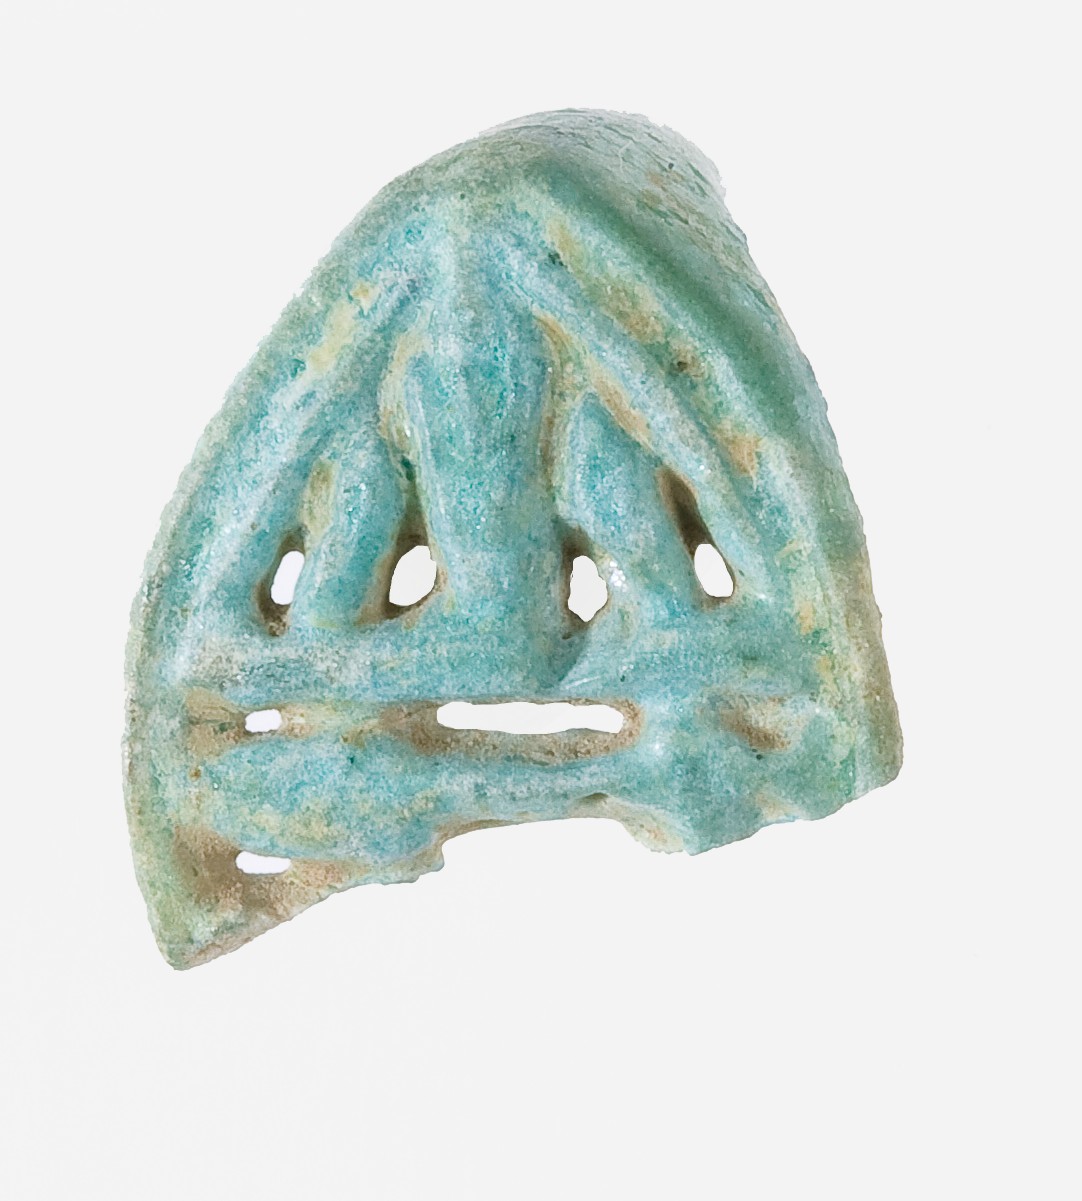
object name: ring fragment, floral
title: Ring Fragment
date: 1390-1352 BCE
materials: faience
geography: egypt